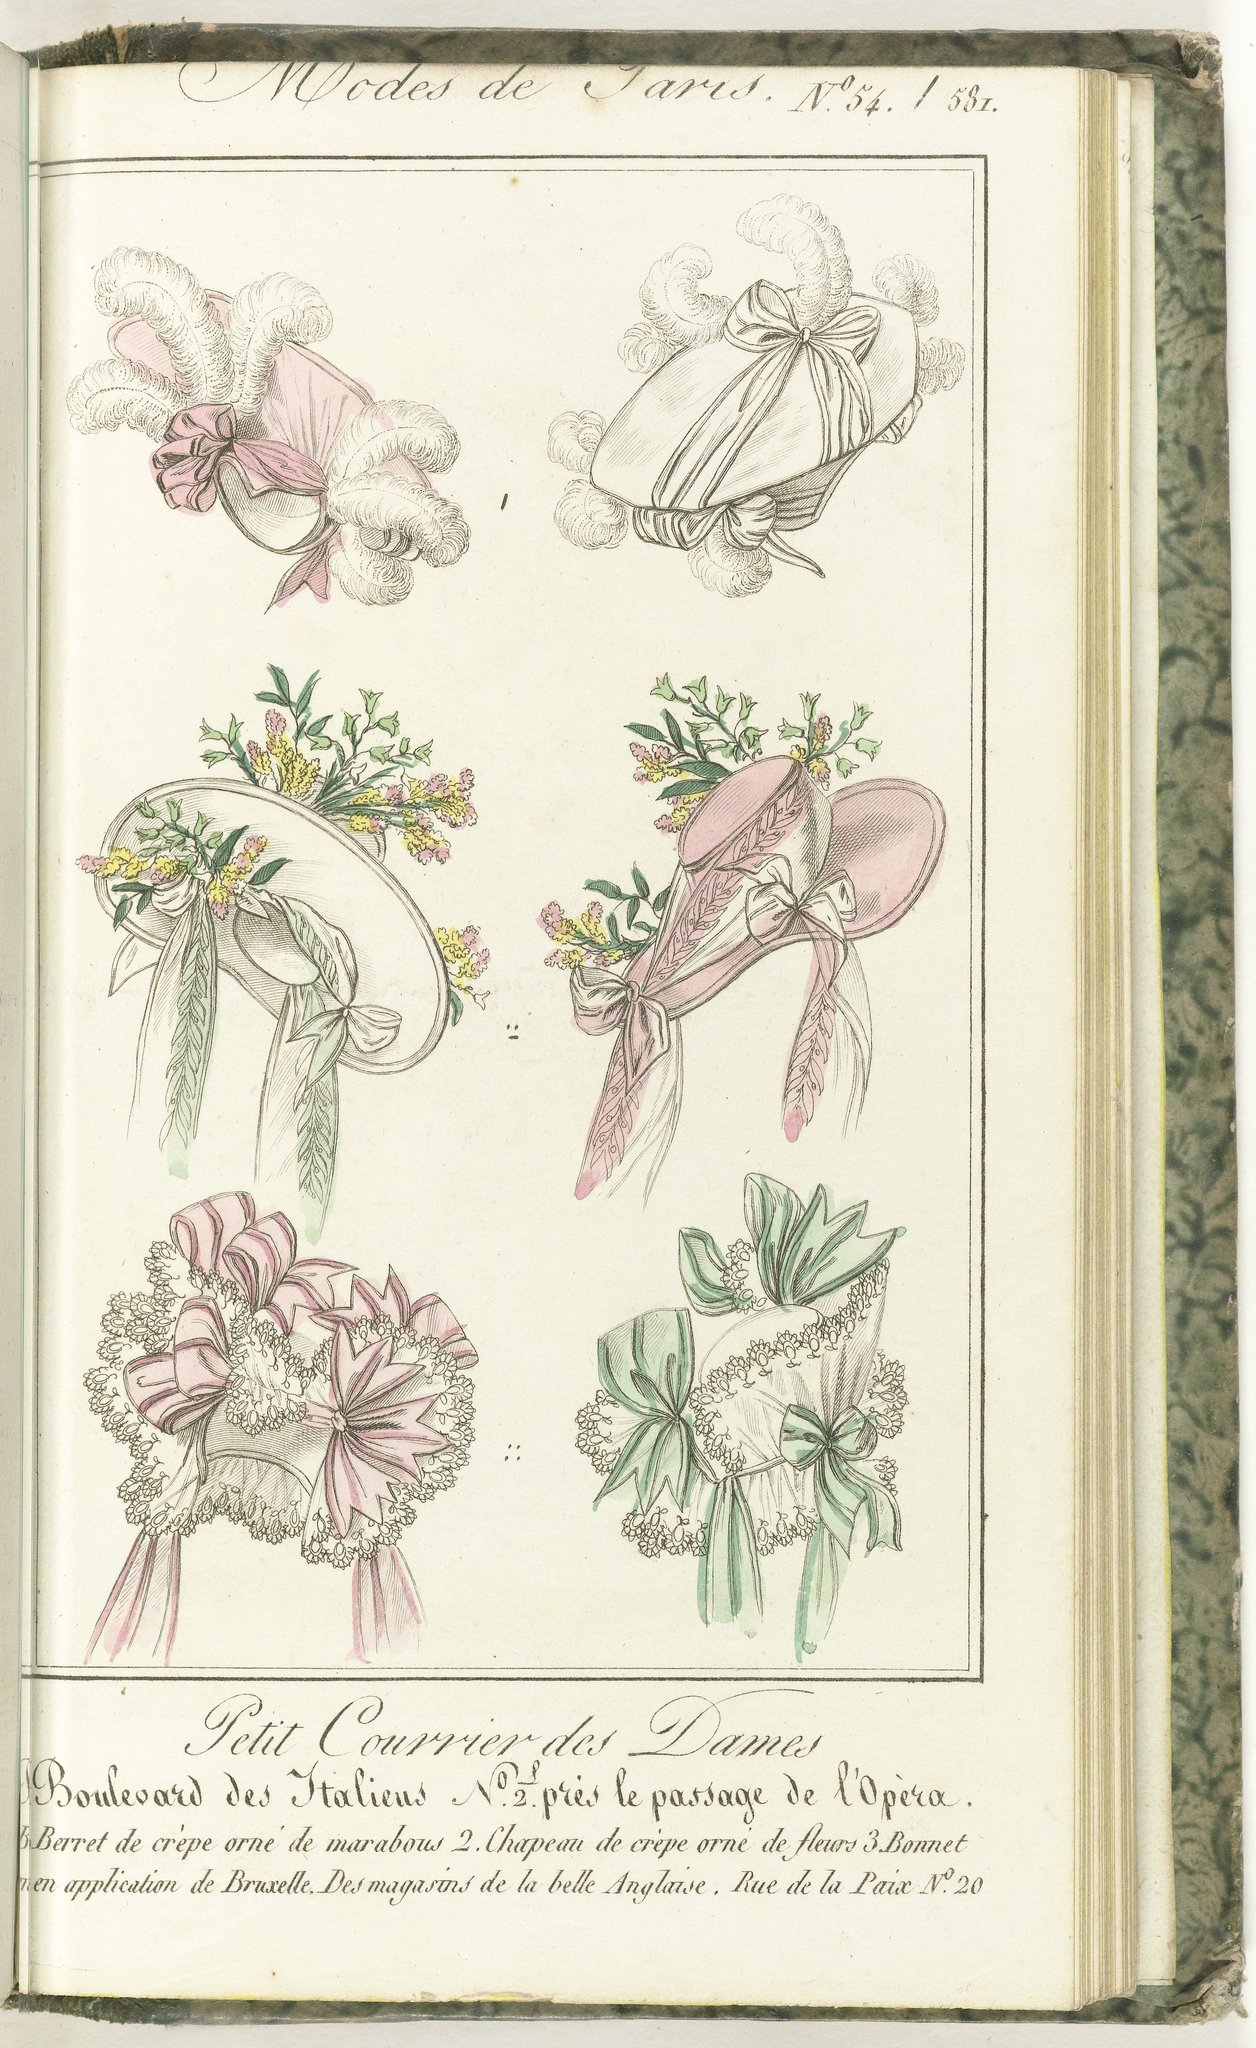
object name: fashion print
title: Petit Courrier des Dames, 10 septembre 1828, No. 54 / 581 : Berret de crèpe orné de marabous...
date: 1828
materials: paper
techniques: engraving, hand coloring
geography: paris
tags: head-gear: beret (+ women's clothes), lace (+ women's clothes), head-gear: cap (+ women's clothes), fashion plates, head-gear: hat (+ women's clothes)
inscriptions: caption: ‘Berret de crèpe orné de marabous 2. Chapeau de crèpe orné de fleurs 3 Bonnet en application de Bruxelle. Des magasins de la belle Anglaise, rue de la Paix No.20’, title: ‘Petit Courrier des Dames.’, title: ‘Modes de Paris.’, address: ‘Boulevard des Italiens No.2 près le passage de l'Opèra.’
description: Drie verschillende hoofddeksels, van de voor- en achterzijde weergegeven, genummerd één tot en met drie. 1. Baret van crêpe versierd met maraboeveren. 2. Hoed van crêpe versierd met bloemen. 3. Muts met applicatie van 'Bruxelle' (kant). Prent uit het modetijdschrift Petit Courrier des Dames (1821-1868). Ingebonden (met enkele pp. Le Journal des Dames et des Modes). 15 Januari 1827 t/m 20 maart 1830. Incompleet.